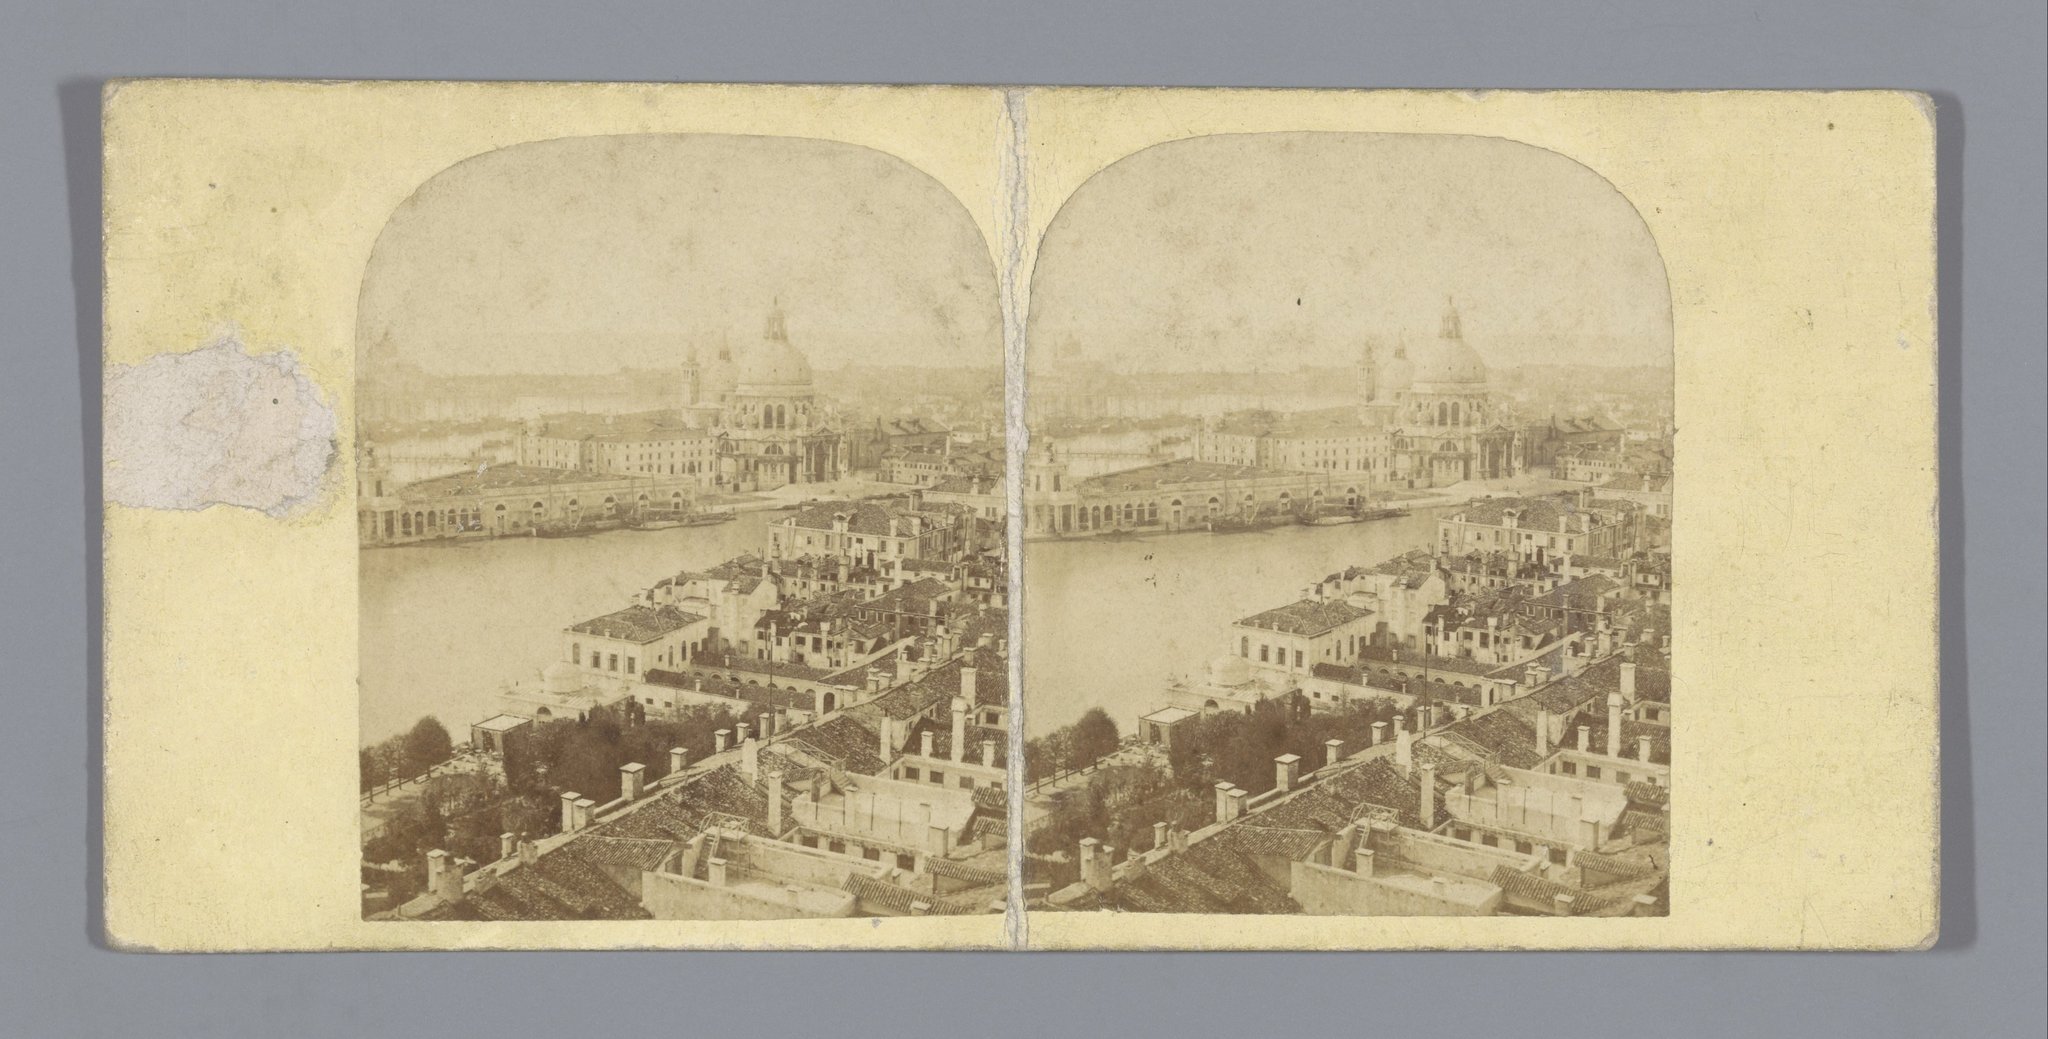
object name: stereograph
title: Gezicht op Venetië vanaf de Campanile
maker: Anonymous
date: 1850-1880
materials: cardboard, photographic support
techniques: albumen print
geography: venice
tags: city-view, and landscape with man-made constructions, venice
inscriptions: number: ‘22. No. 5.’